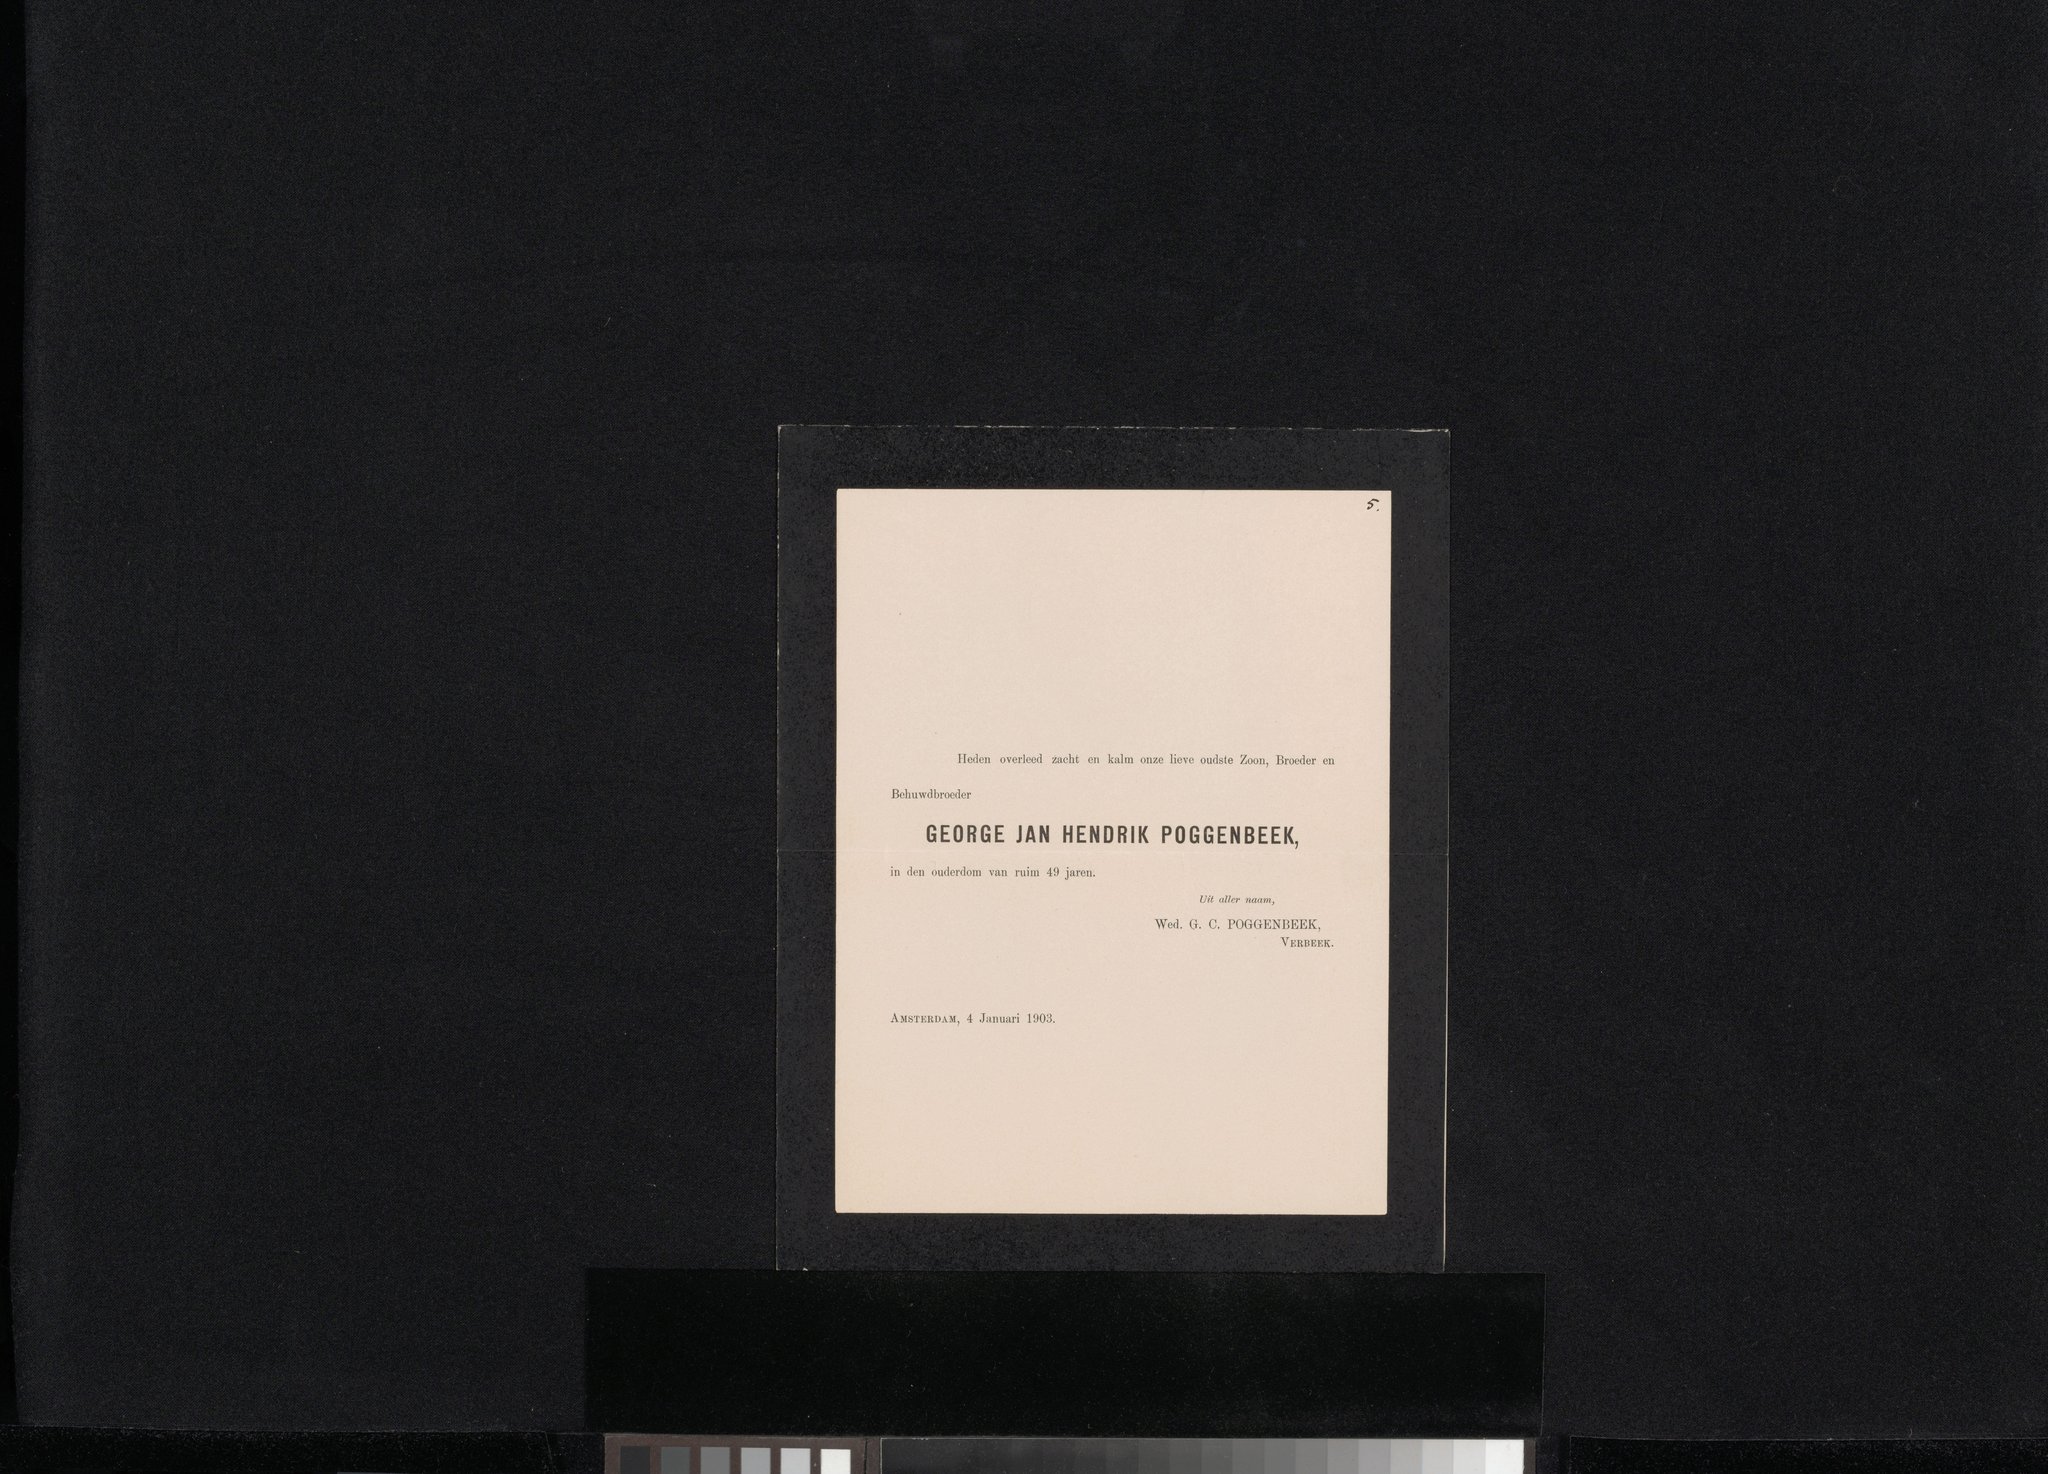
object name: overlijdensbericht, overlijdensadvertentie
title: Overlijdensbericht aan Nico van Harpen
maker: Anonymous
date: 1903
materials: paper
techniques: pen, printing, writing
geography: amsterdam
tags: painter, print maker, draughtsman, geo poggenbeek, nico van harpen